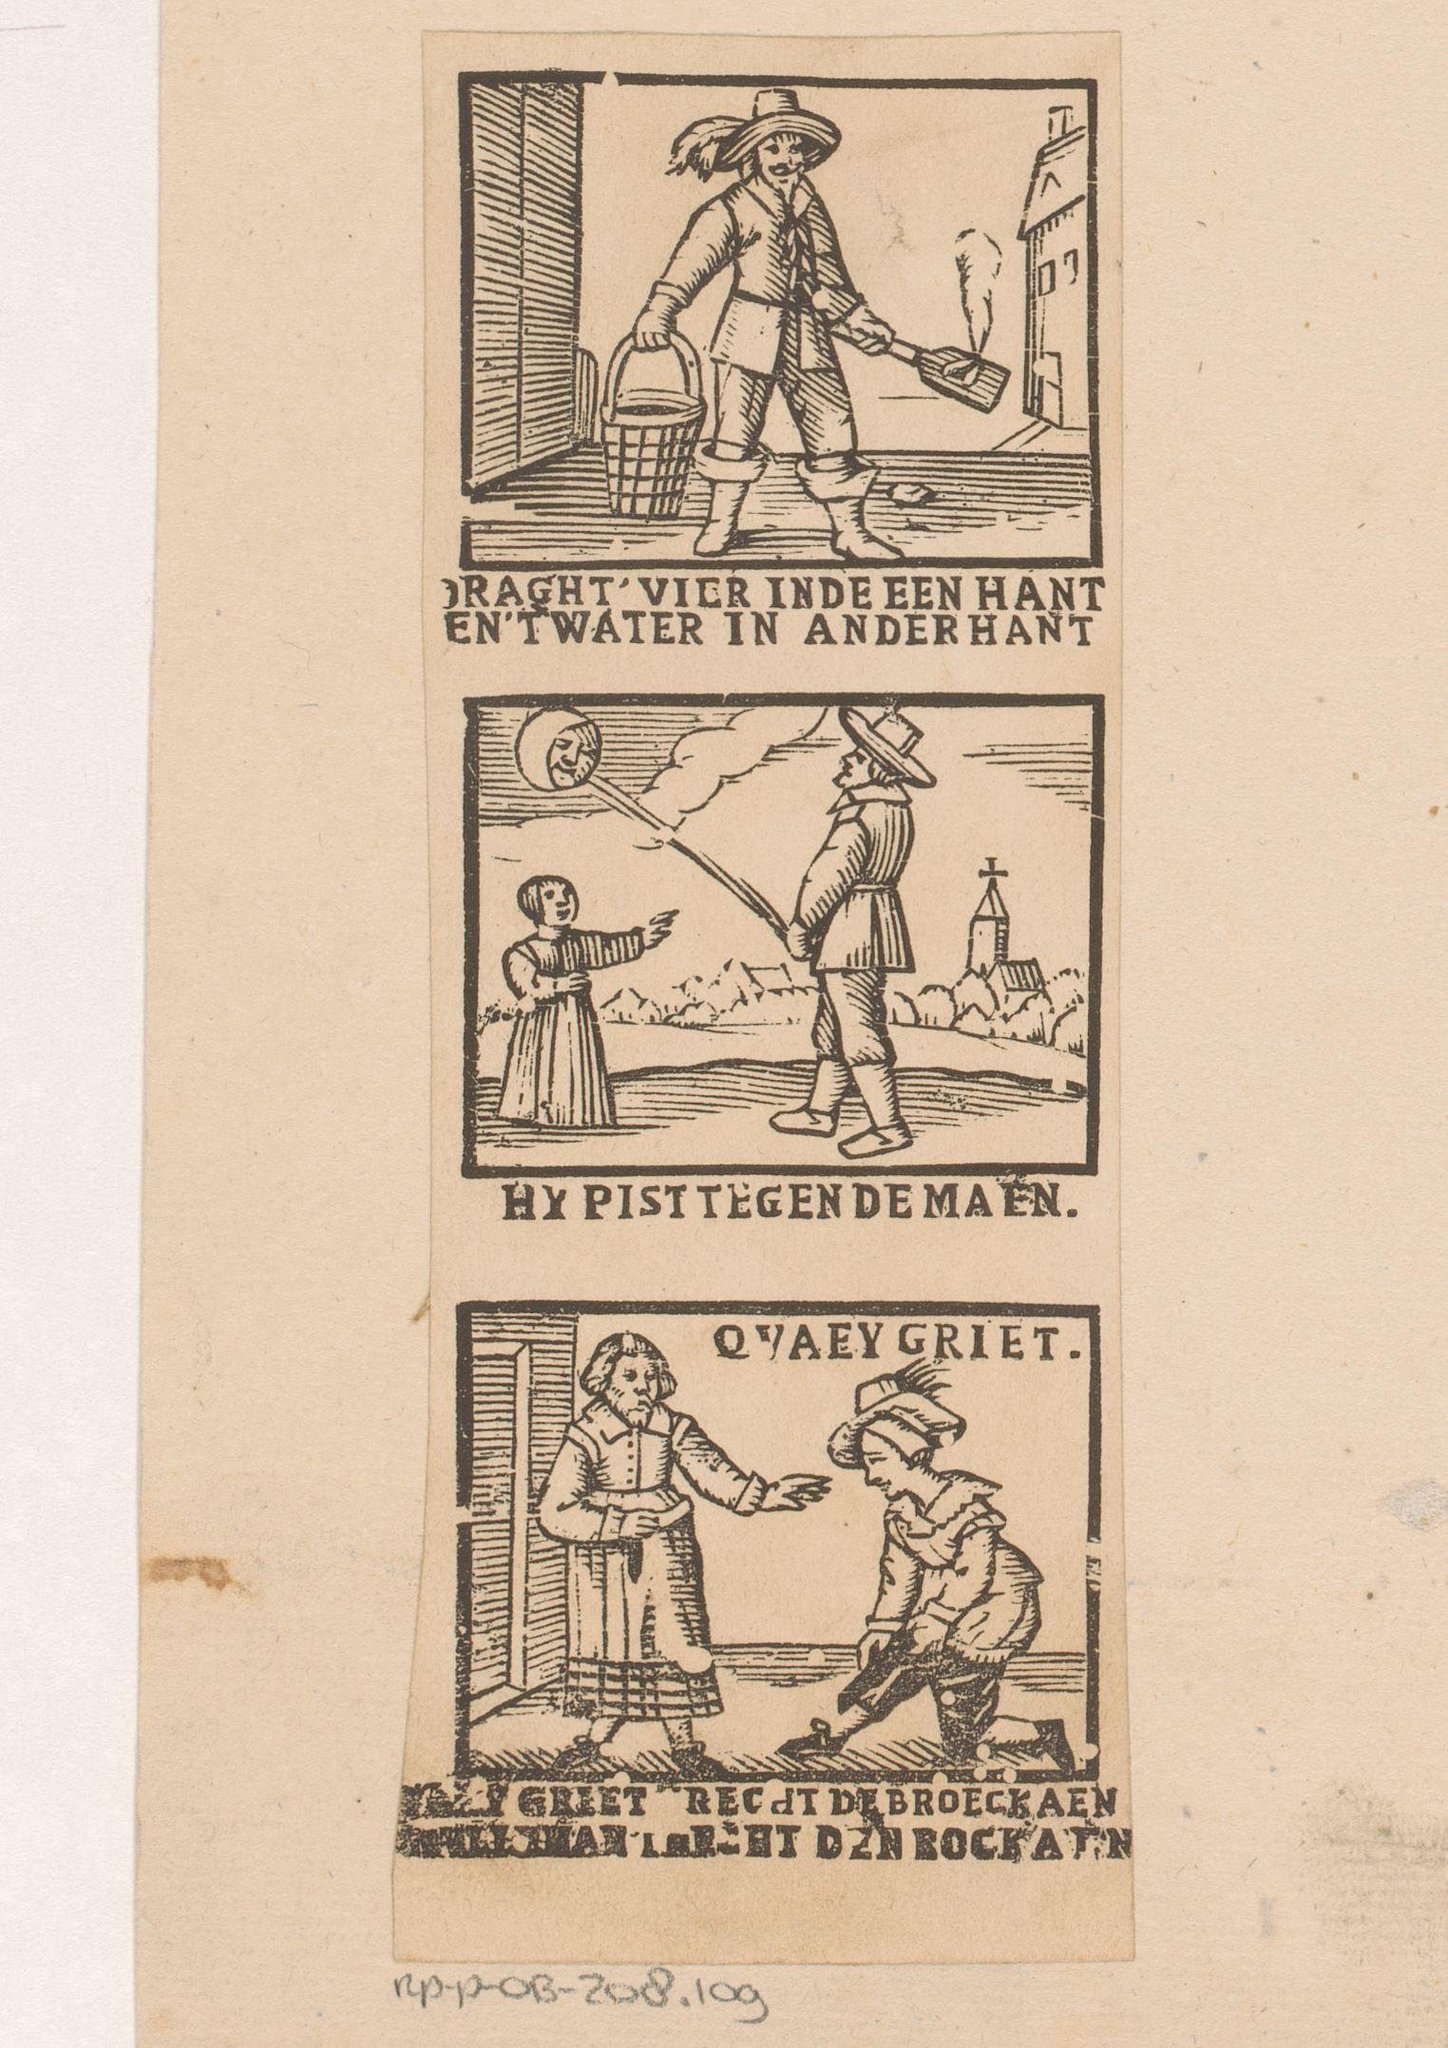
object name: popular print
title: Afbeeldingh hoe seven wyven vechten om een mans broeck ende de vrou de broeck aentrecht [(...)]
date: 1700-1725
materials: paper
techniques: woodcut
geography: low countries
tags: proverbs, sayings, etc.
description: Blad met 3 voorstellingen van spreekwoorden, waaronder 'Hy pist tegen de maen'. Onder elke afbeelding een onderschrift.